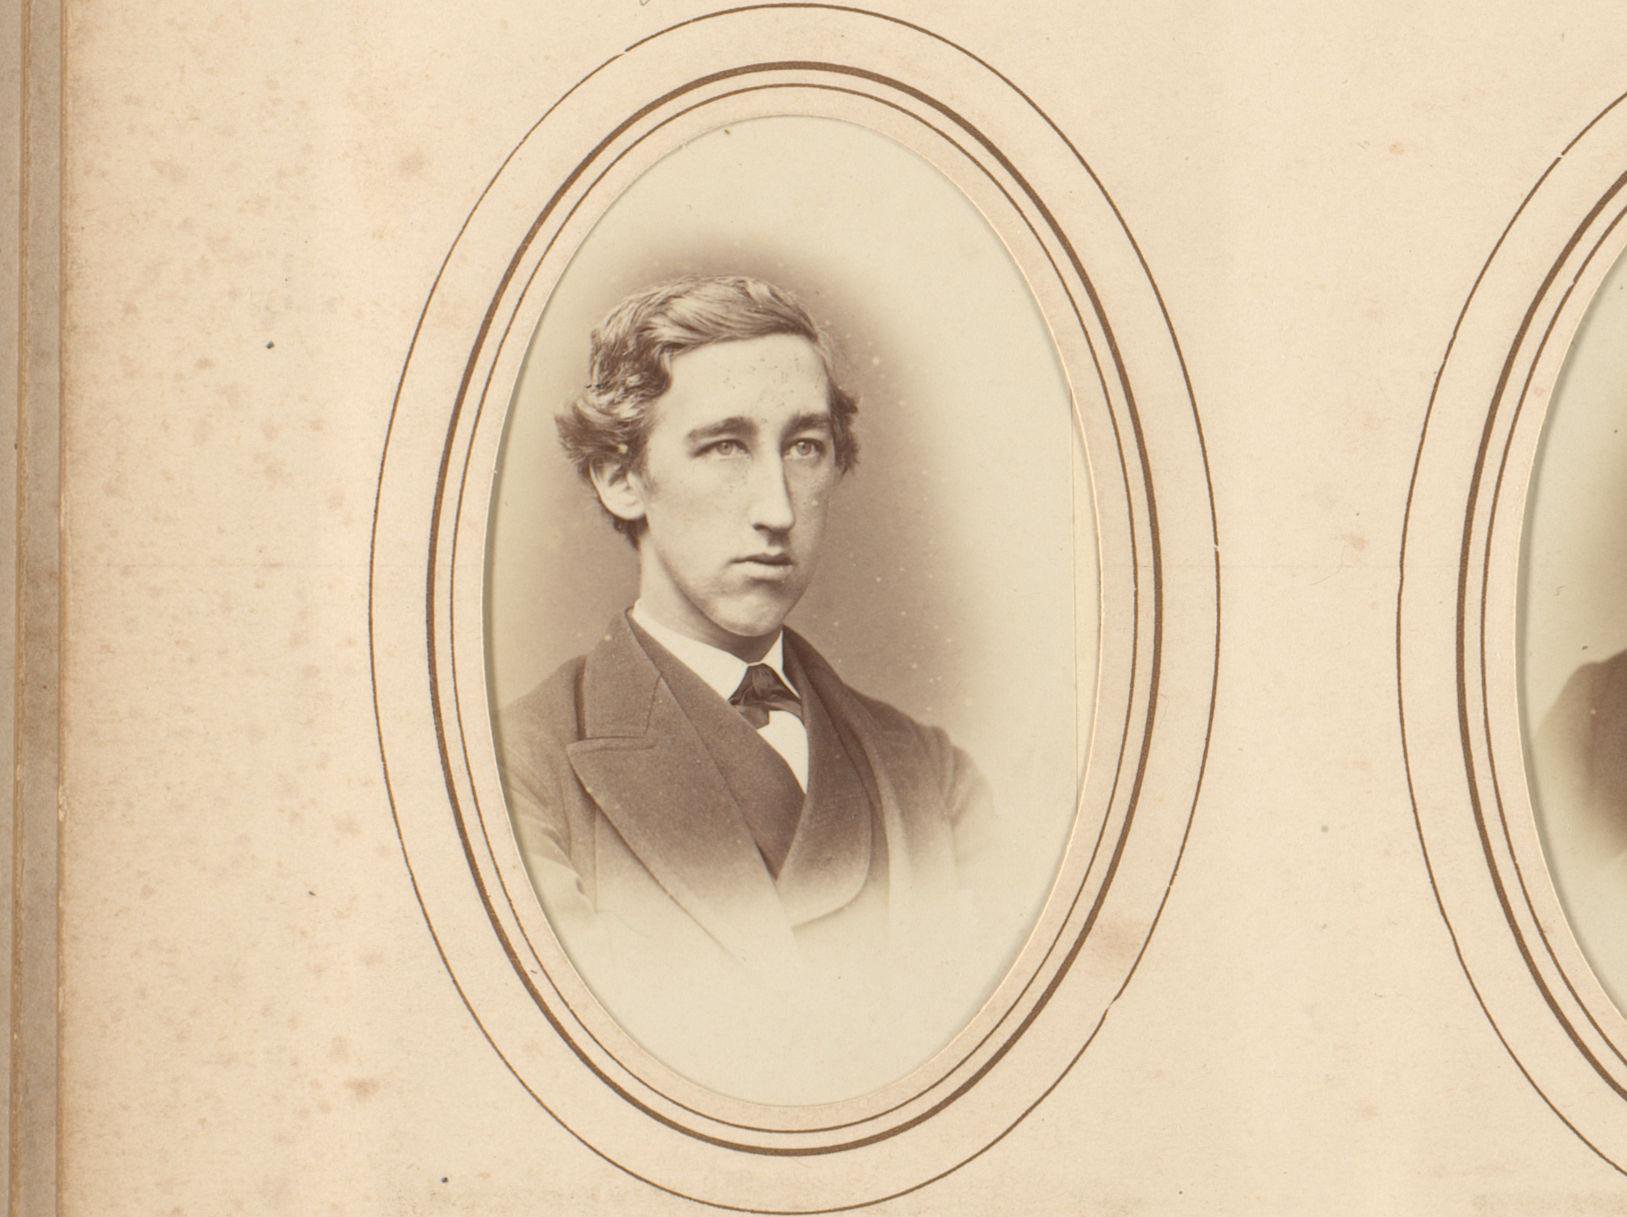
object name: photograph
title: Portret van een man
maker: gerardus johannes mulder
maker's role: hoogleraar, scheikundige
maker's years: 1802-1880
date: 1860-1885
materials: cardboard, photographic support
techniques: albumen print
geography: utrecht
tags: adult man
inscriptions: inscription: ‘G.L. Mulder / Utrecht.’, inscription: ‘GLM/ Photogr. Atelier/ G.L. Mulder/ van Wijckskade H. 326./ Utrecht.’